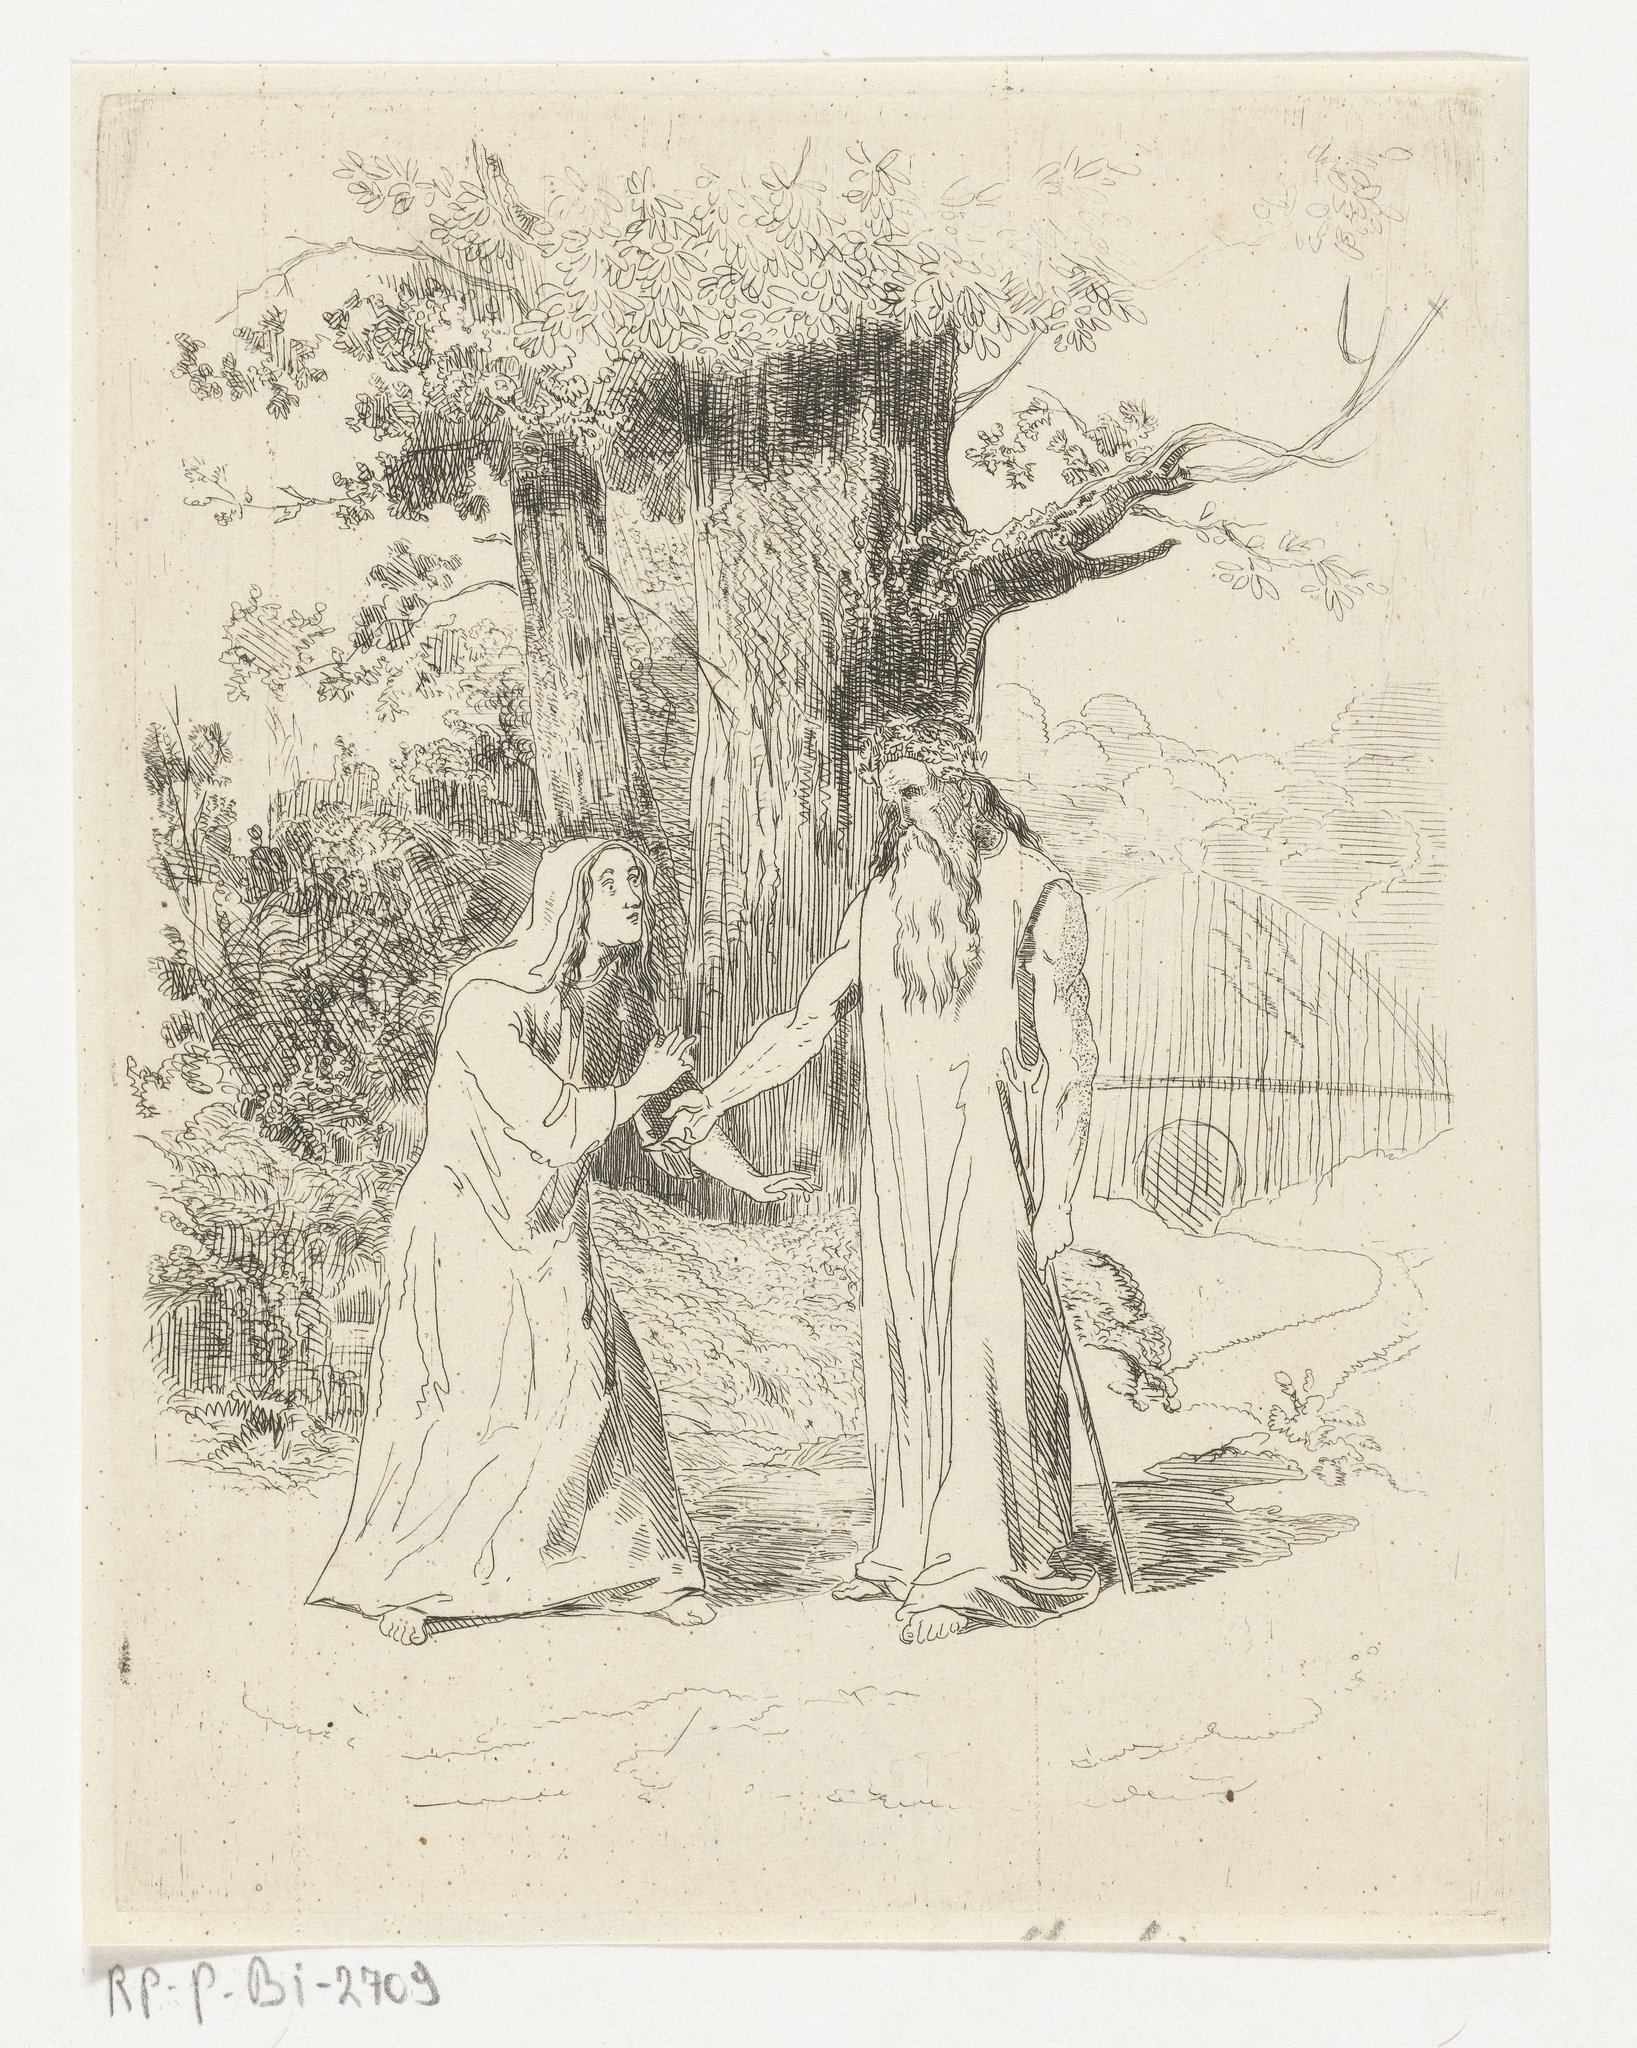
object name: book illustration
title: Aeddon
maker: karel frederik bombled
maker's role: draughtsman, print maker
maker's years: 1822-1902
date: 1852-1902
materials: paper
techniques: etching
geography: delft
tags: fringe, edge of the wood, druid (celtic religious functionary), tales and fairy tales (aeddon), extinct, 'historical' peoples: gauls (+ men)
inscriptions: collector's mark: Lugt 2228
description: Aan de rand van het dorp staat Hudlath de wichelaar, een oude druïde met een krans van eikenblad en een eiken staf. Finkoma, de moeder van Olwene staat tegenover hem en hoort zijn voorspelling aan. Illustratie bij de derde zang van het episch lofgedicht Aeddon